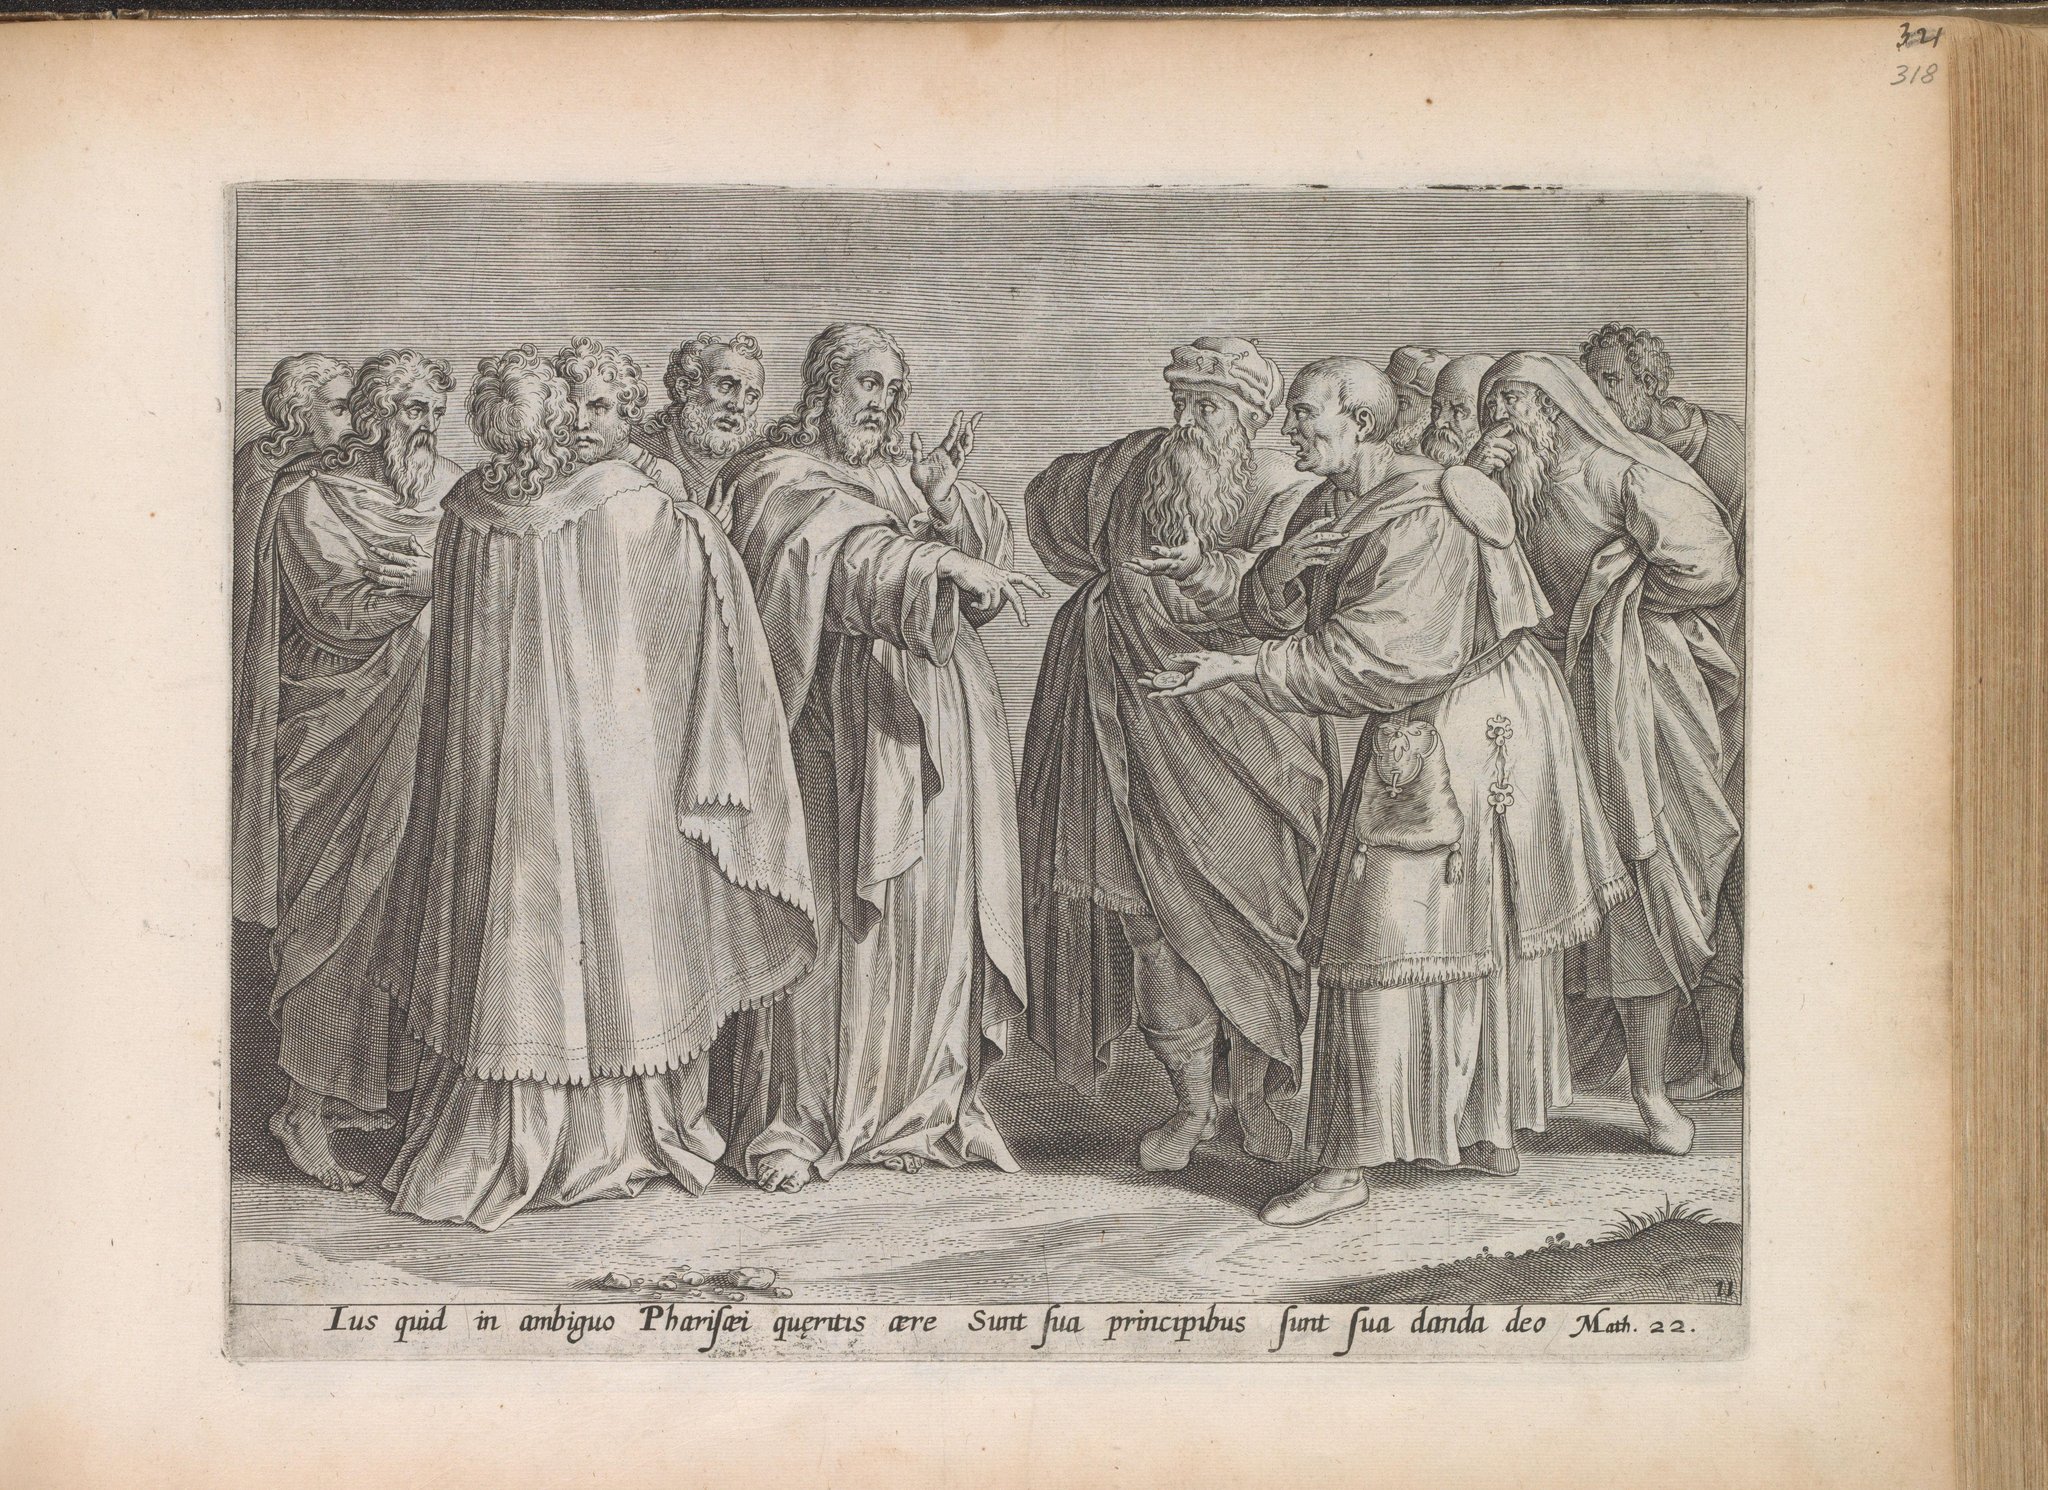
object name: album leaf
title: Christus in debat met de farizeeën over de belasting aan de keizer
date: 1585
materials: paper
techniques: engraving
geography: amsterdam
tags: christ (in the temple) in debate with pharisees about the tribute to caesar (matthew 22:15-22; mark 12:13-17; luke 20:20-26)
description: Christus in debat met de farizeeën. Achter hem staan zijn leerlingen. Een van de farizeeën toont hem een munt en vraagt aan Christus of het toegestaan is belasting aan de keizer te betalen. Onder de voorstelling een verwijzing in het Latijn naar de Bijbeltekst in Mat. 22. Deze prent maakt deel uit van een album.